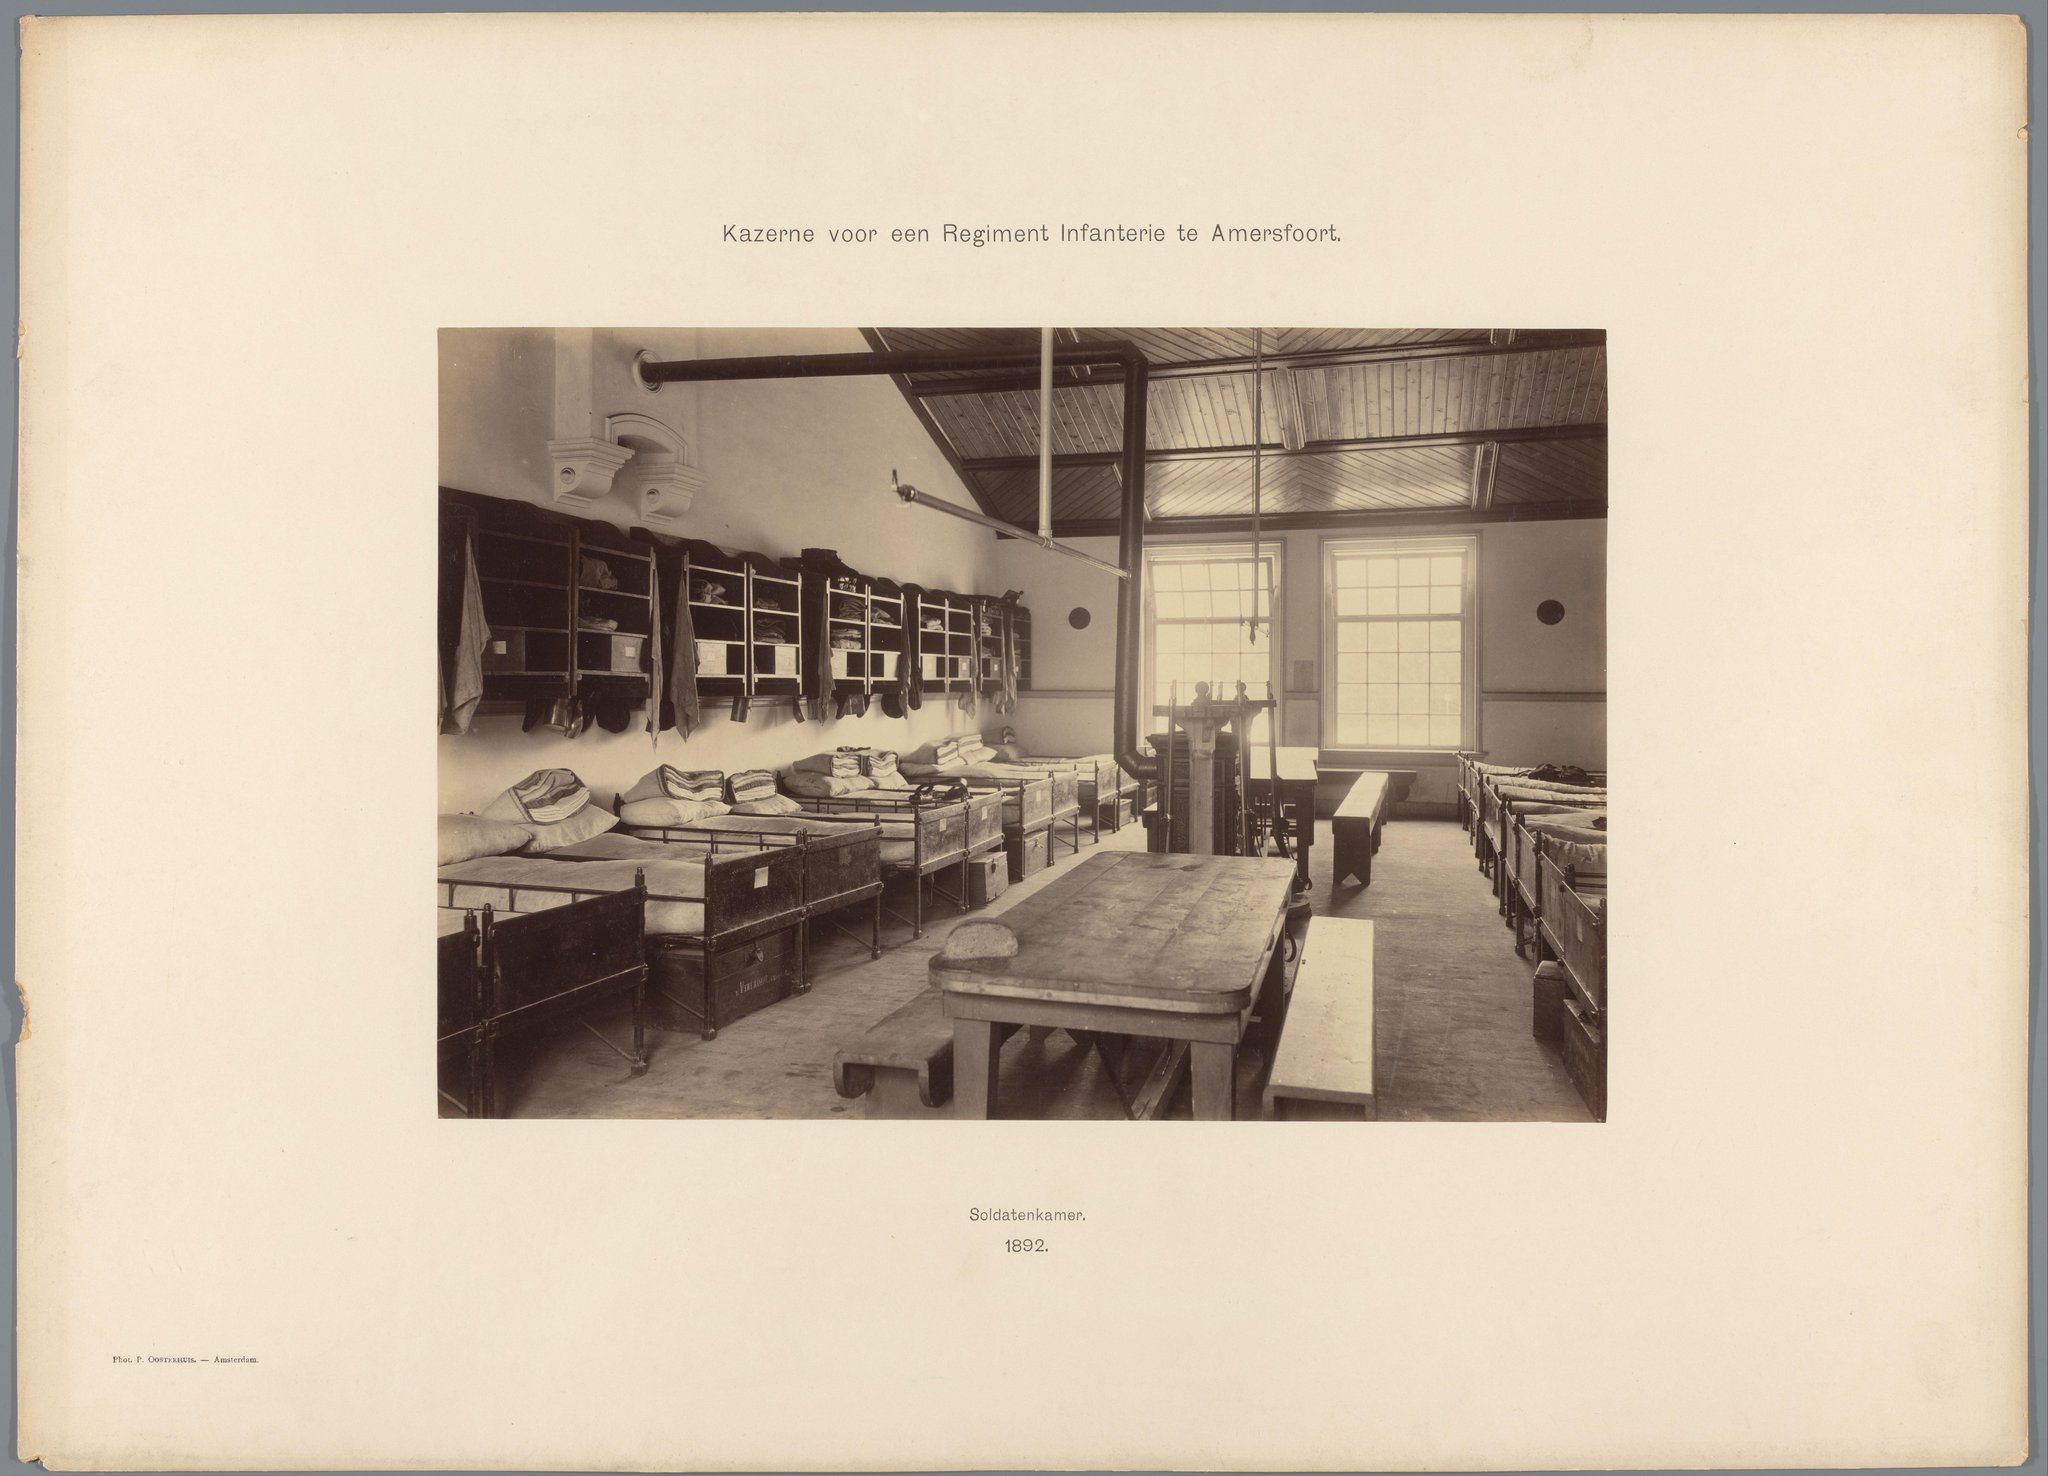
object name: photograph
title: Kazerne voor een Regiment Infanterie te Amersfoort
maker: p. oosterhuis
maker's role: fotograaf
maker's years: 1816-1885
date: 1892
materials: cardboard, paper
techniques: photography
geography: amersfoort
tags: netherlands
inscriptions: date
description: Foto, geelbruin, op karton, met boven titel en onder omschrijving. Opschrift; m.o.: 'soldatenkamer'.